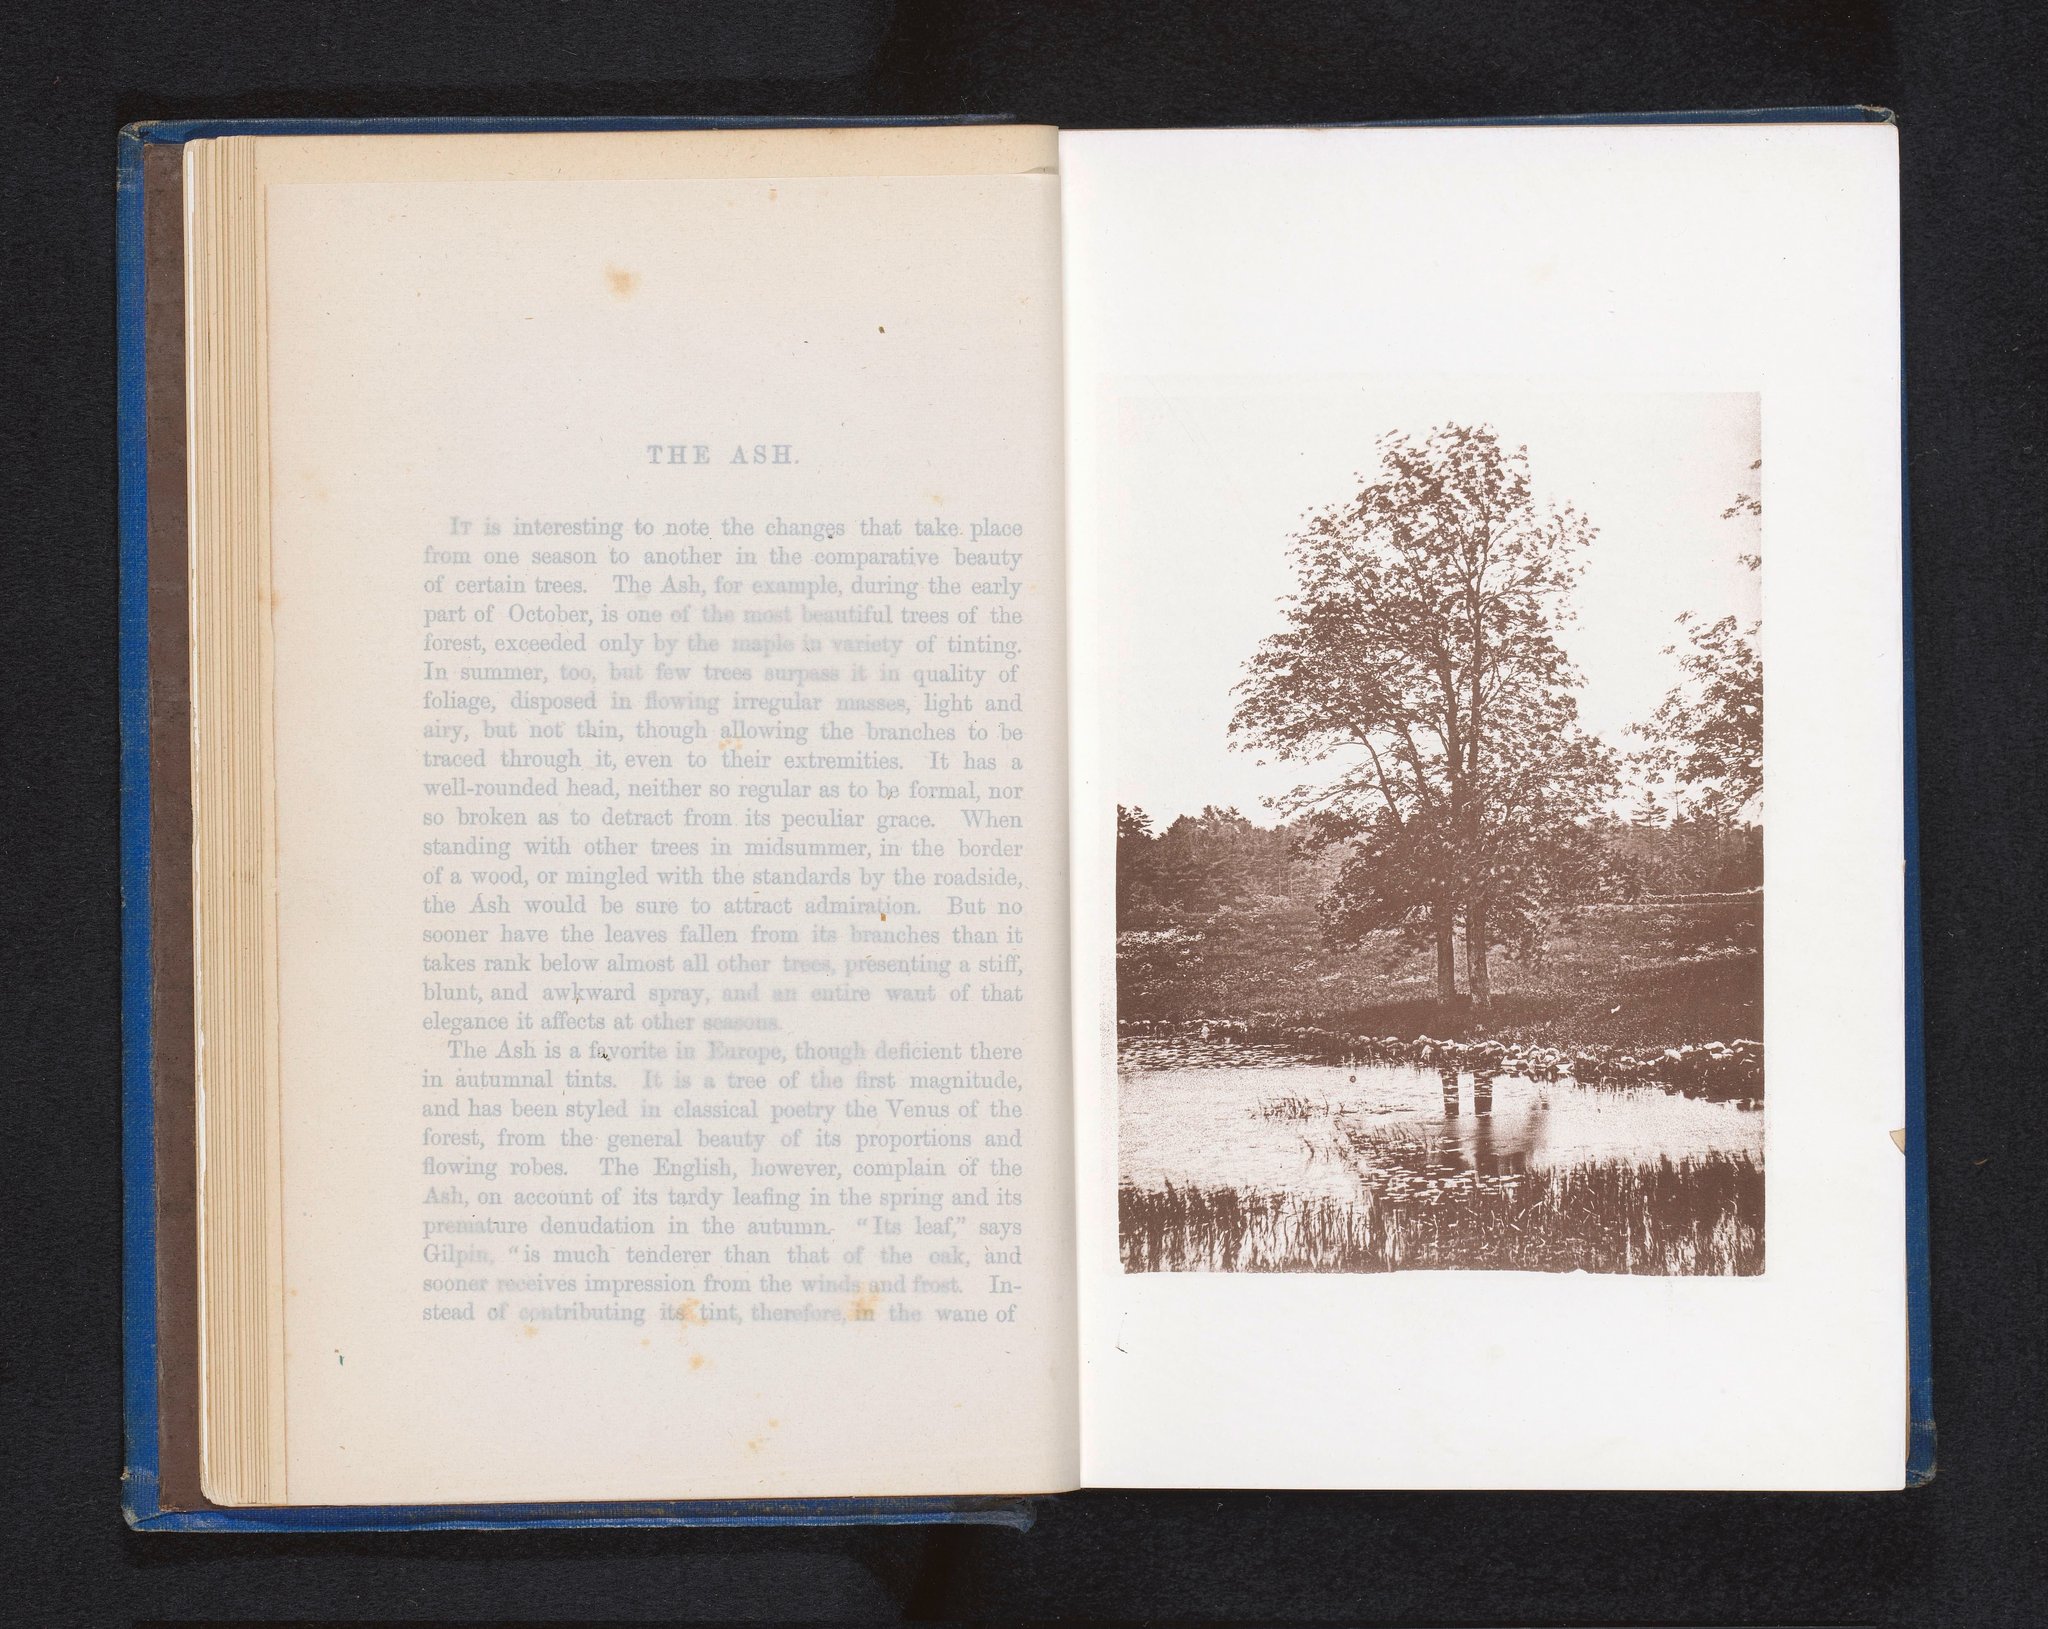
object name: photomechanical print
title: Gezicht op een es bij Turtle Pond te Beverly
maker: Anonymous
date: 1872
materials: paper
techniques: photograph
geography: beverly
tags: trees: ash-tree, pond, pool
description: Prent op tweede ongenummerde pagina na pagina 7.